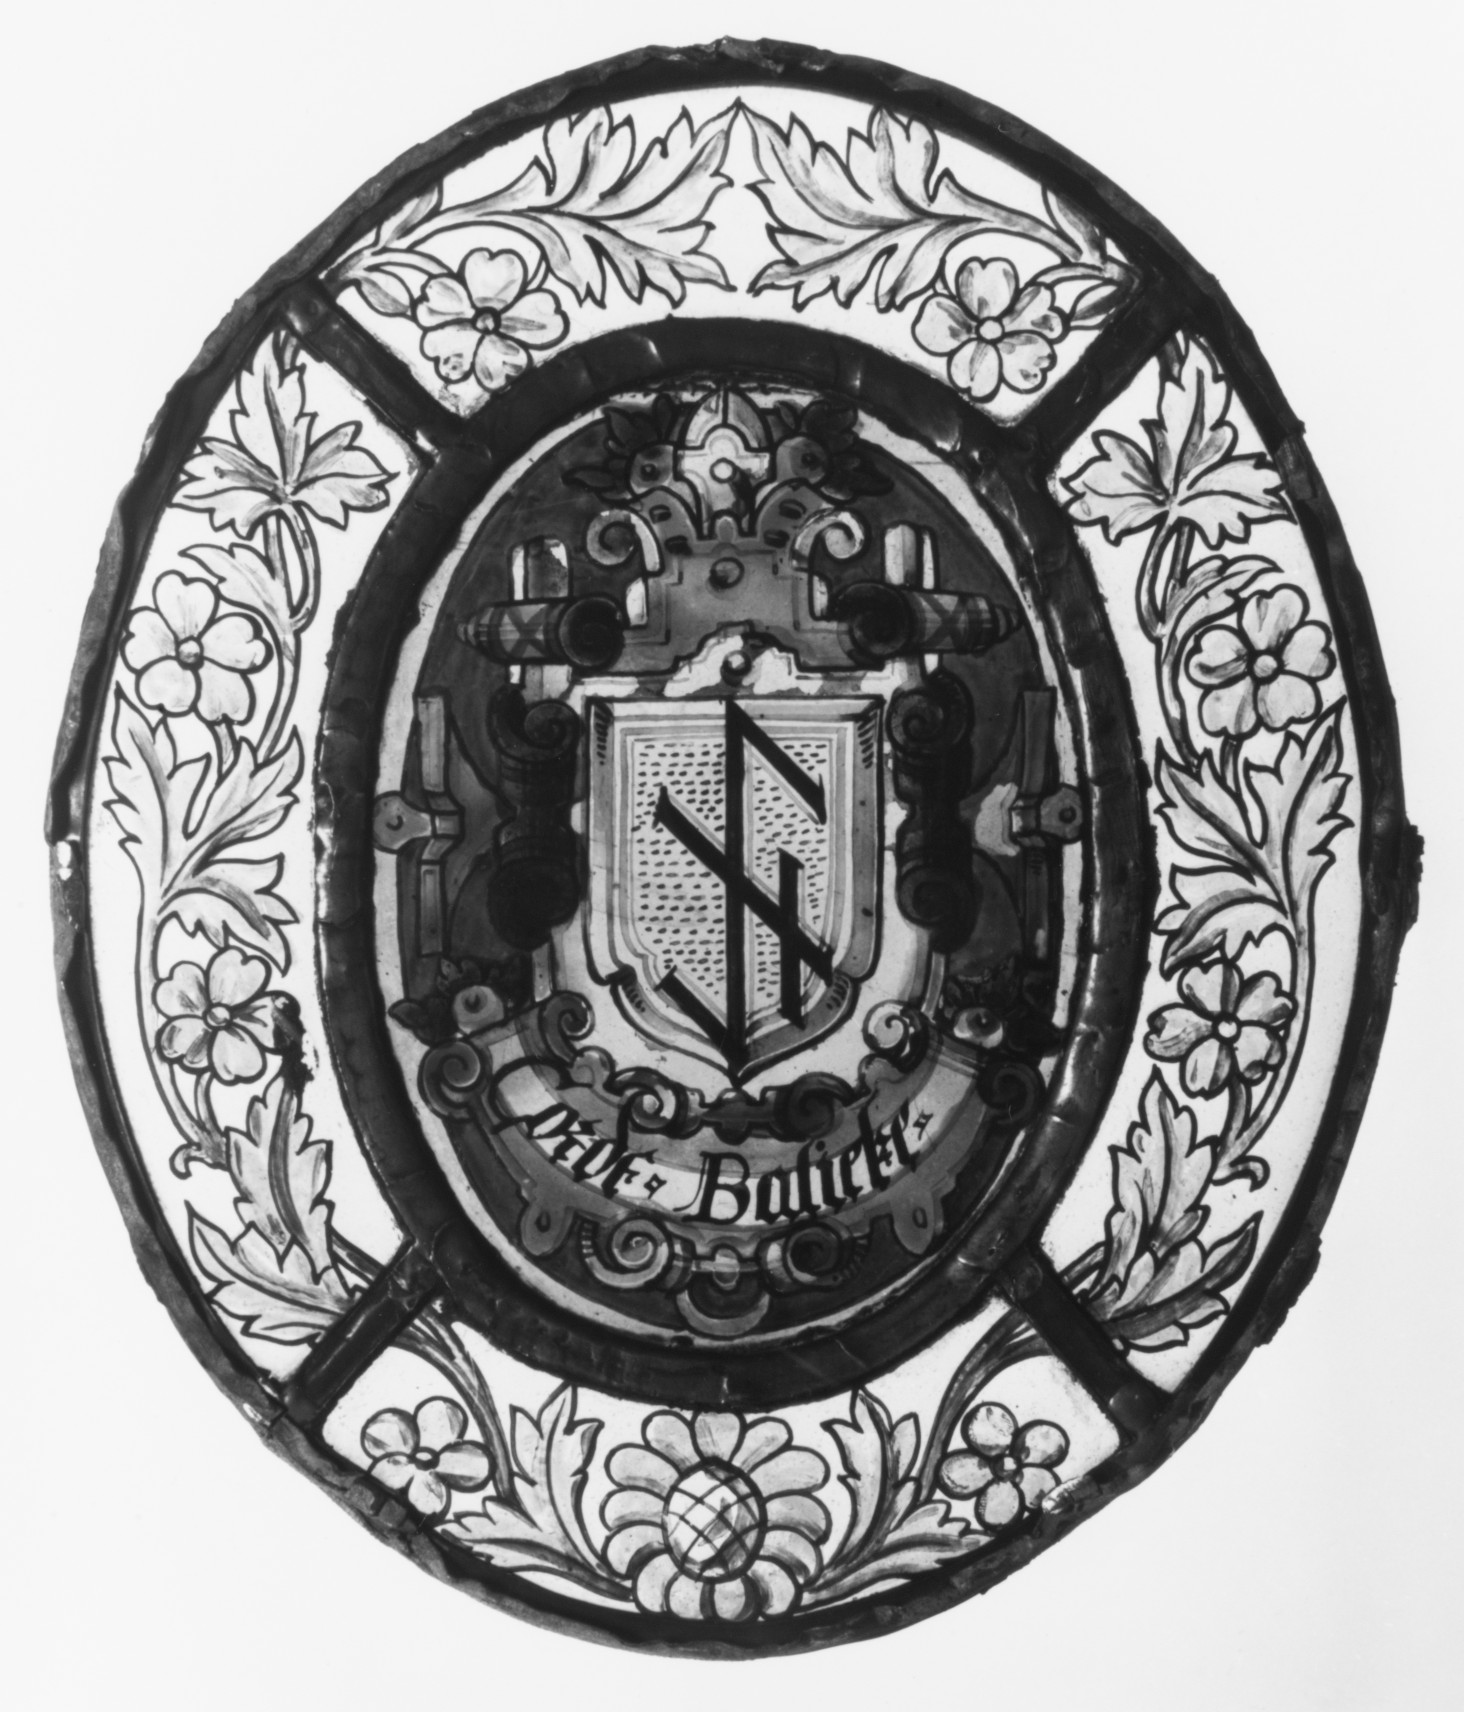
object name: armorial panel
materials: glass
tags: flowers,leaves,insignia